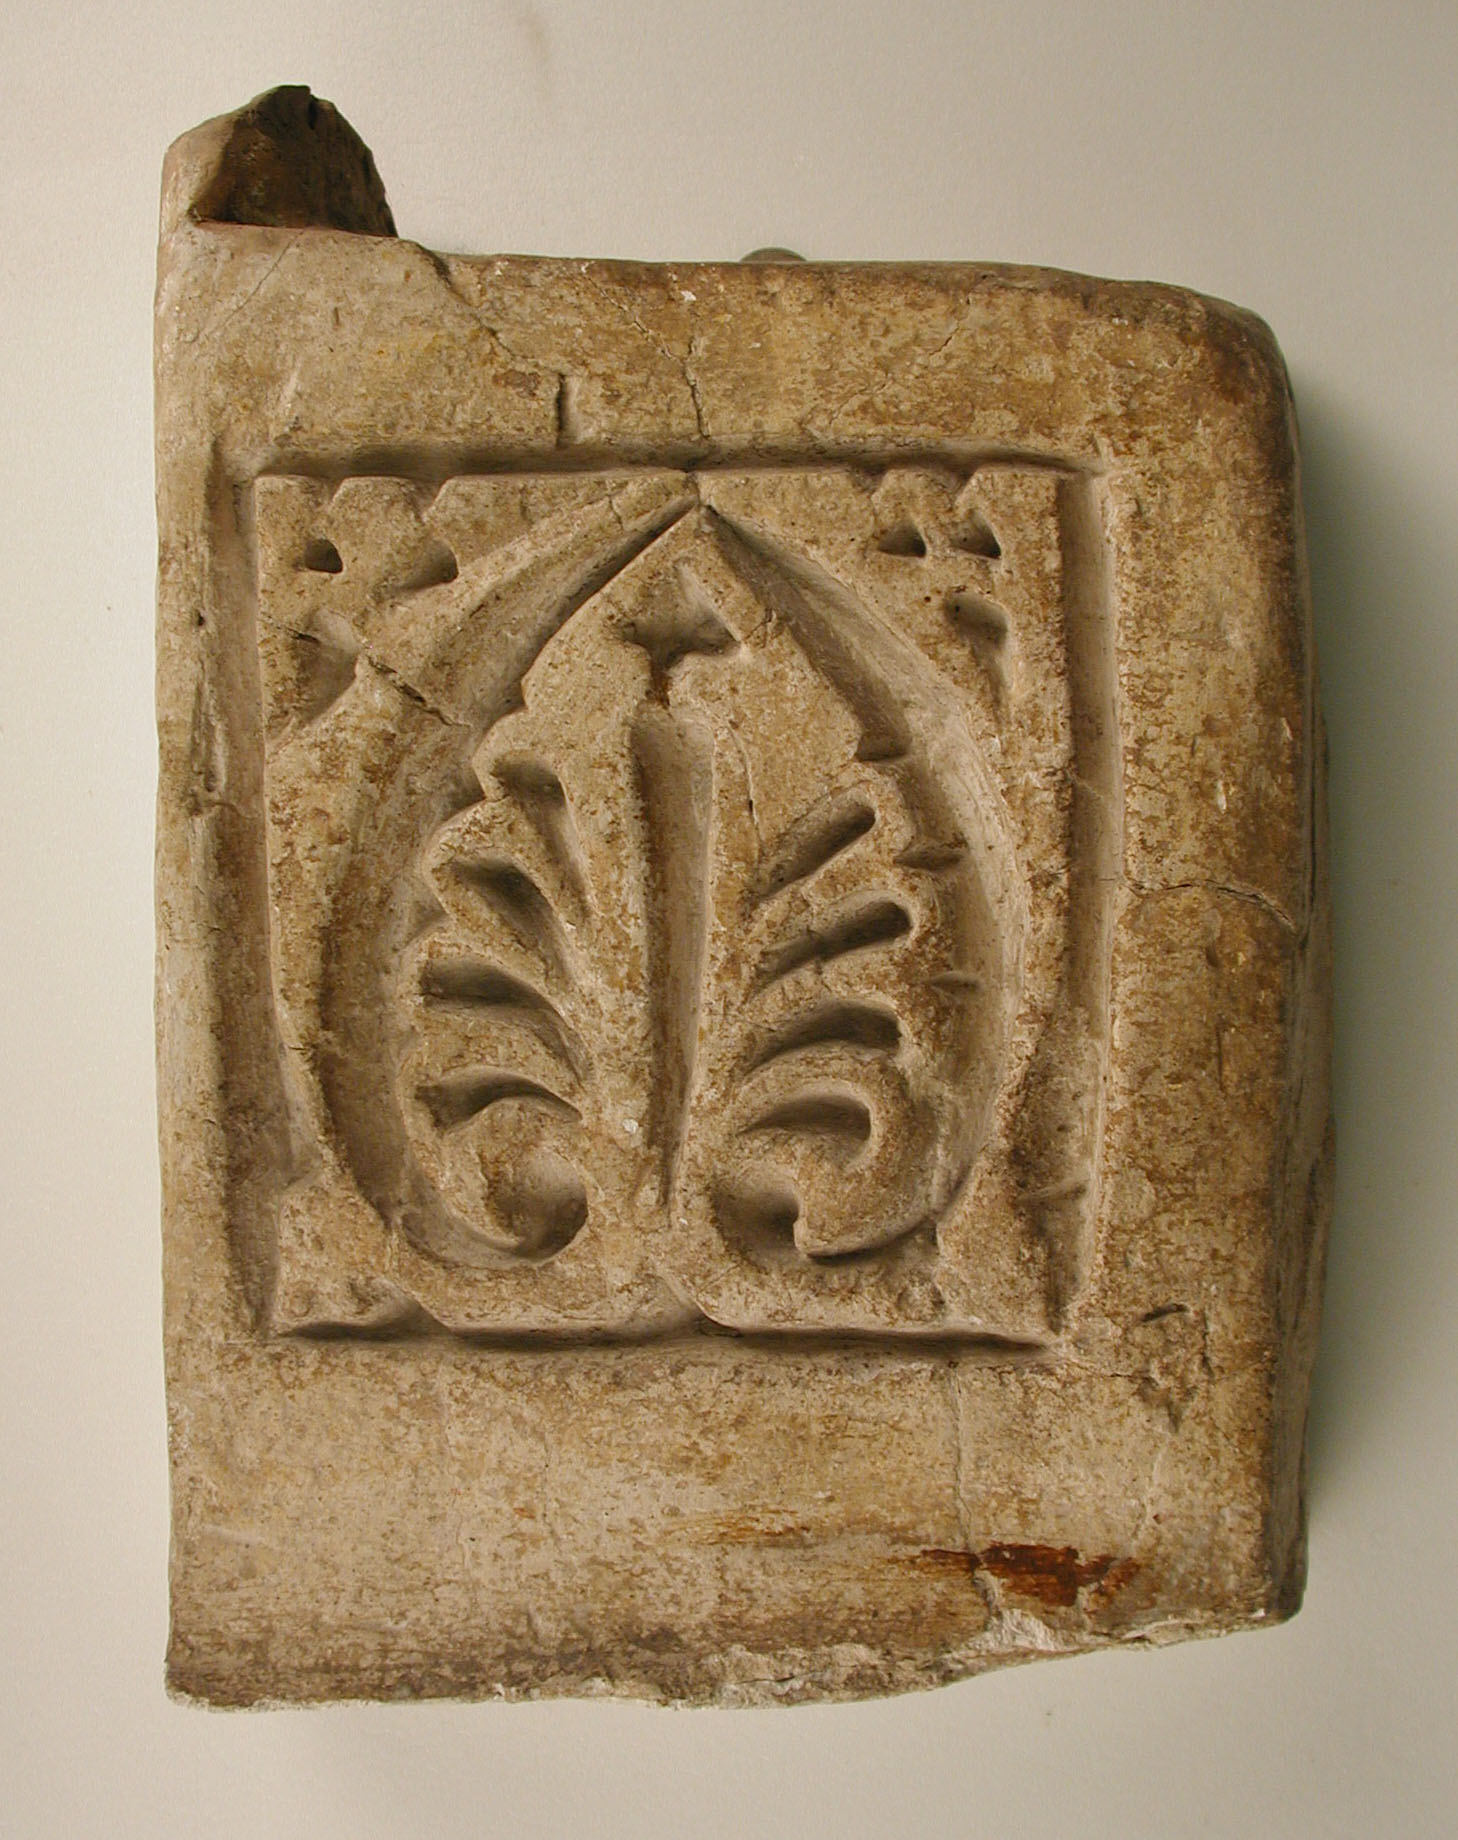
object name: dado panel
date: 901-1000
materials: plaster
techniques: carving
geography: iran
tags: leaves